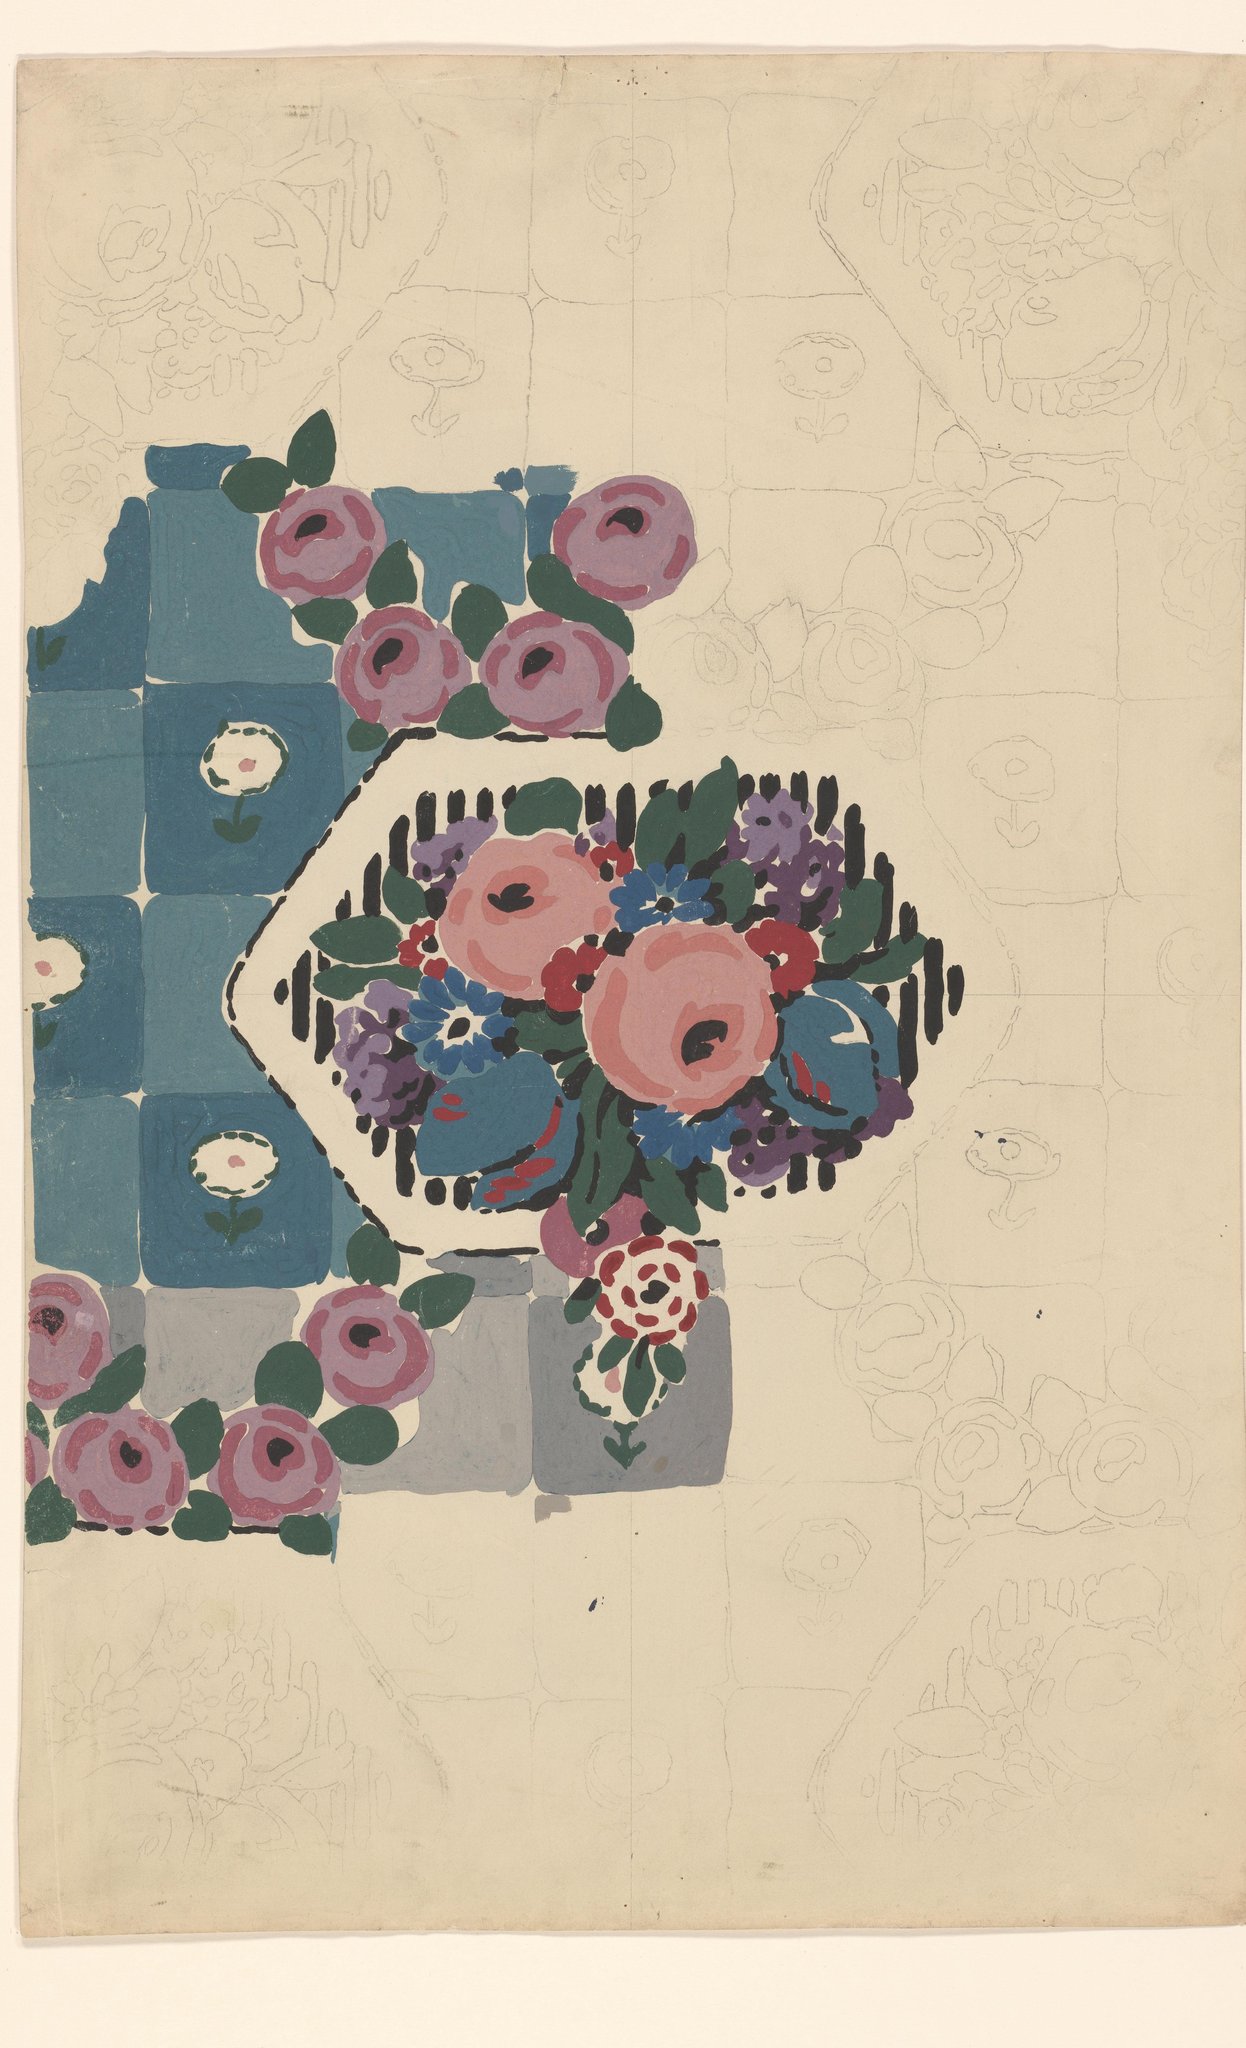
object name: design drawing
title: Ontwerp voor zijden stof voor sjaals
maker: Anonymous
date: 1925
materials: gouache, graphite, paper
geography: paris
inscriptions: inscription: ‘1925 soies [sous?] carres et echarpes’